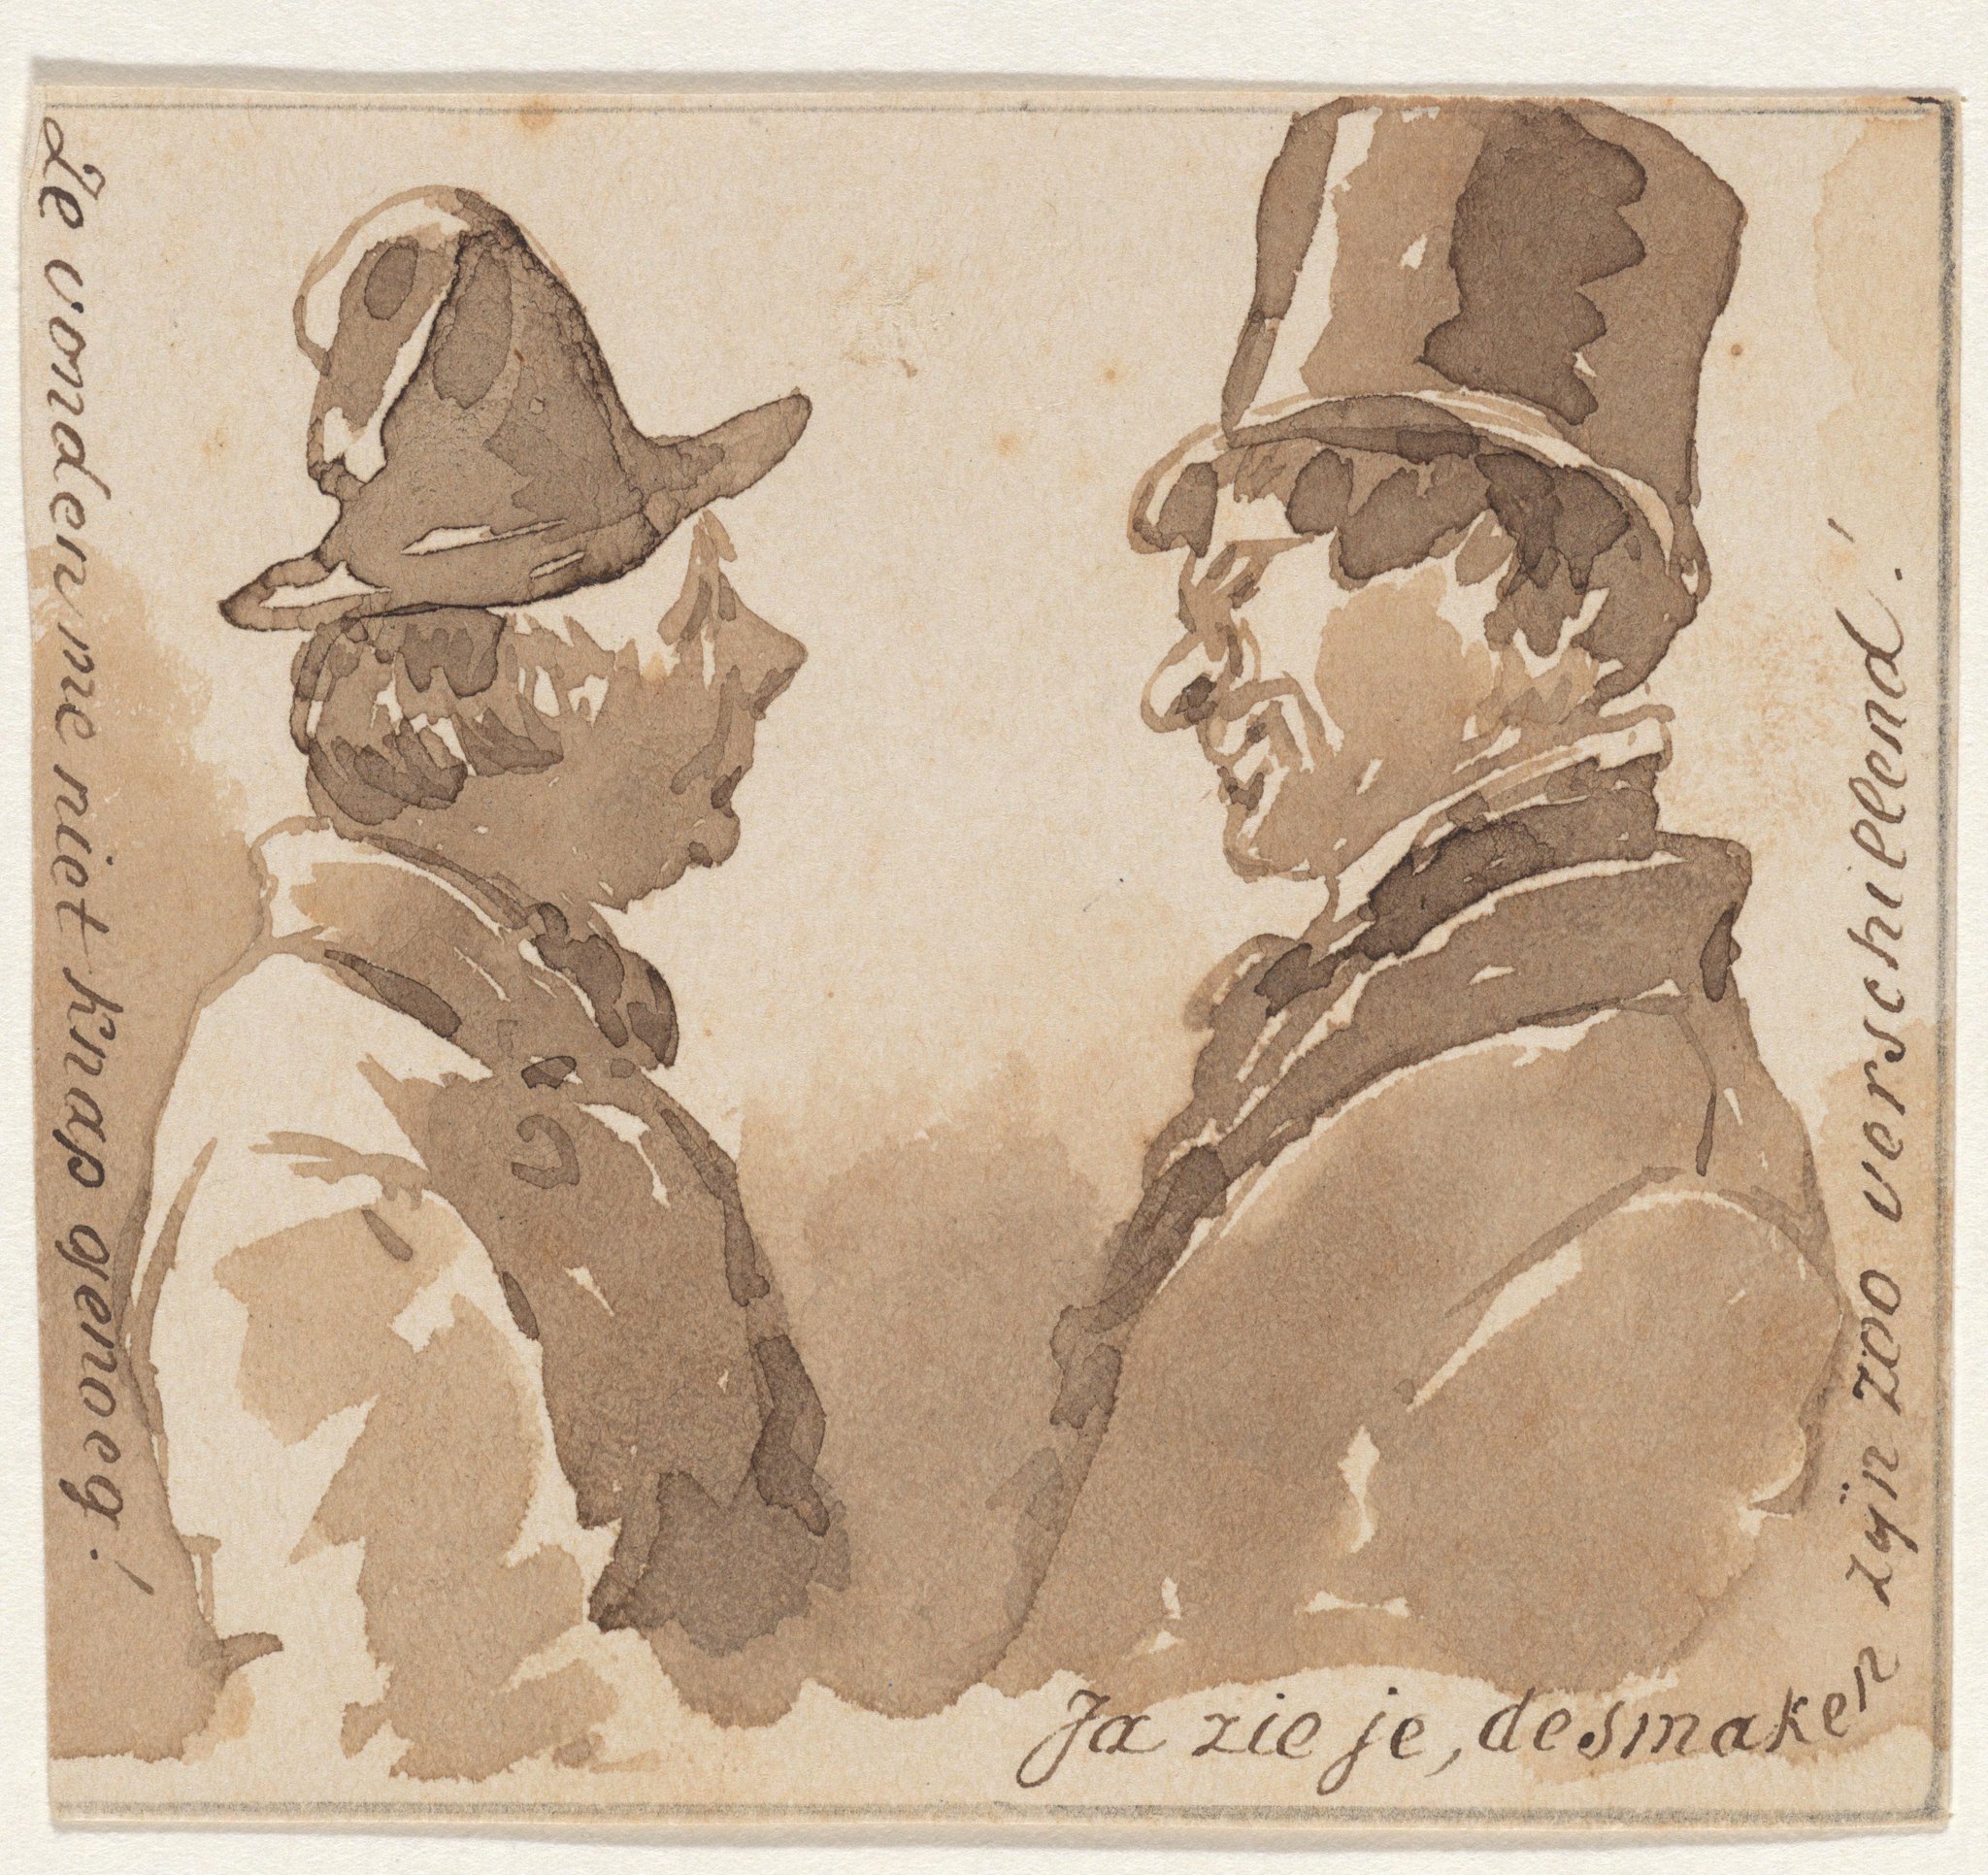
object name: drawing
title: Twee heren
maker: pieter van loon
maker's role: draughtsman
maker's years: 1801-1873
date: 1811-1873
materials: paper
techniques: brush, pen